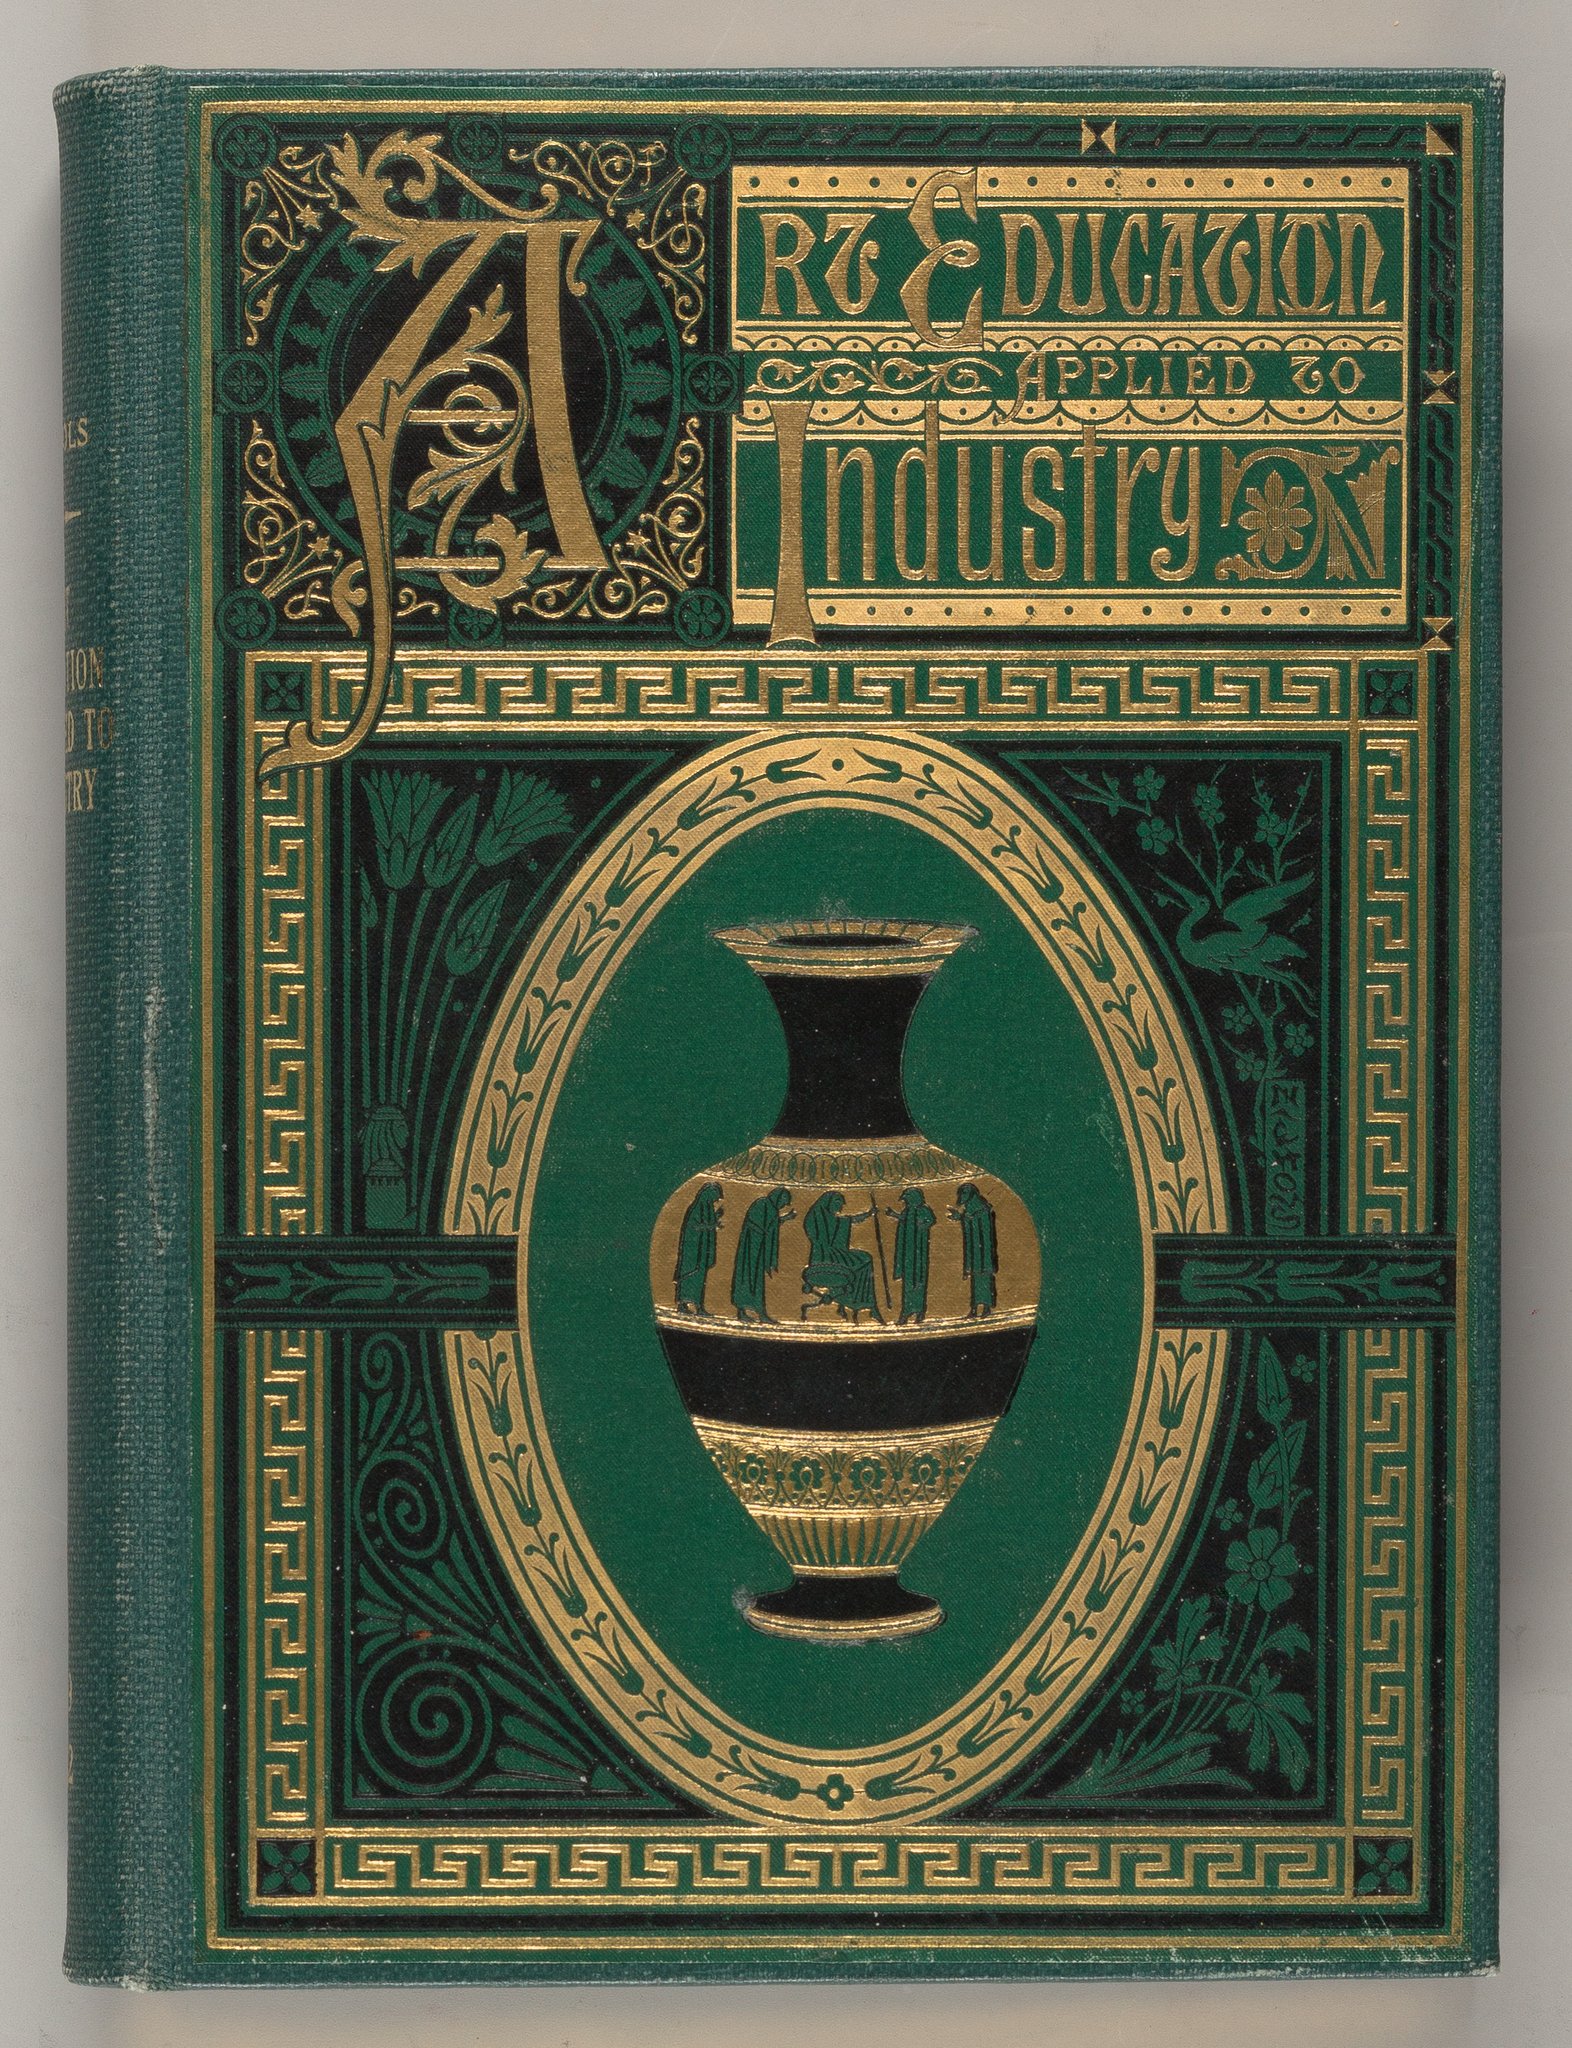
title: Art education applied to industry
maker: george ward nichols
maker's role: author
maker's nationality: american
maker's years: 1831-1885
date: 1877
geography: united states